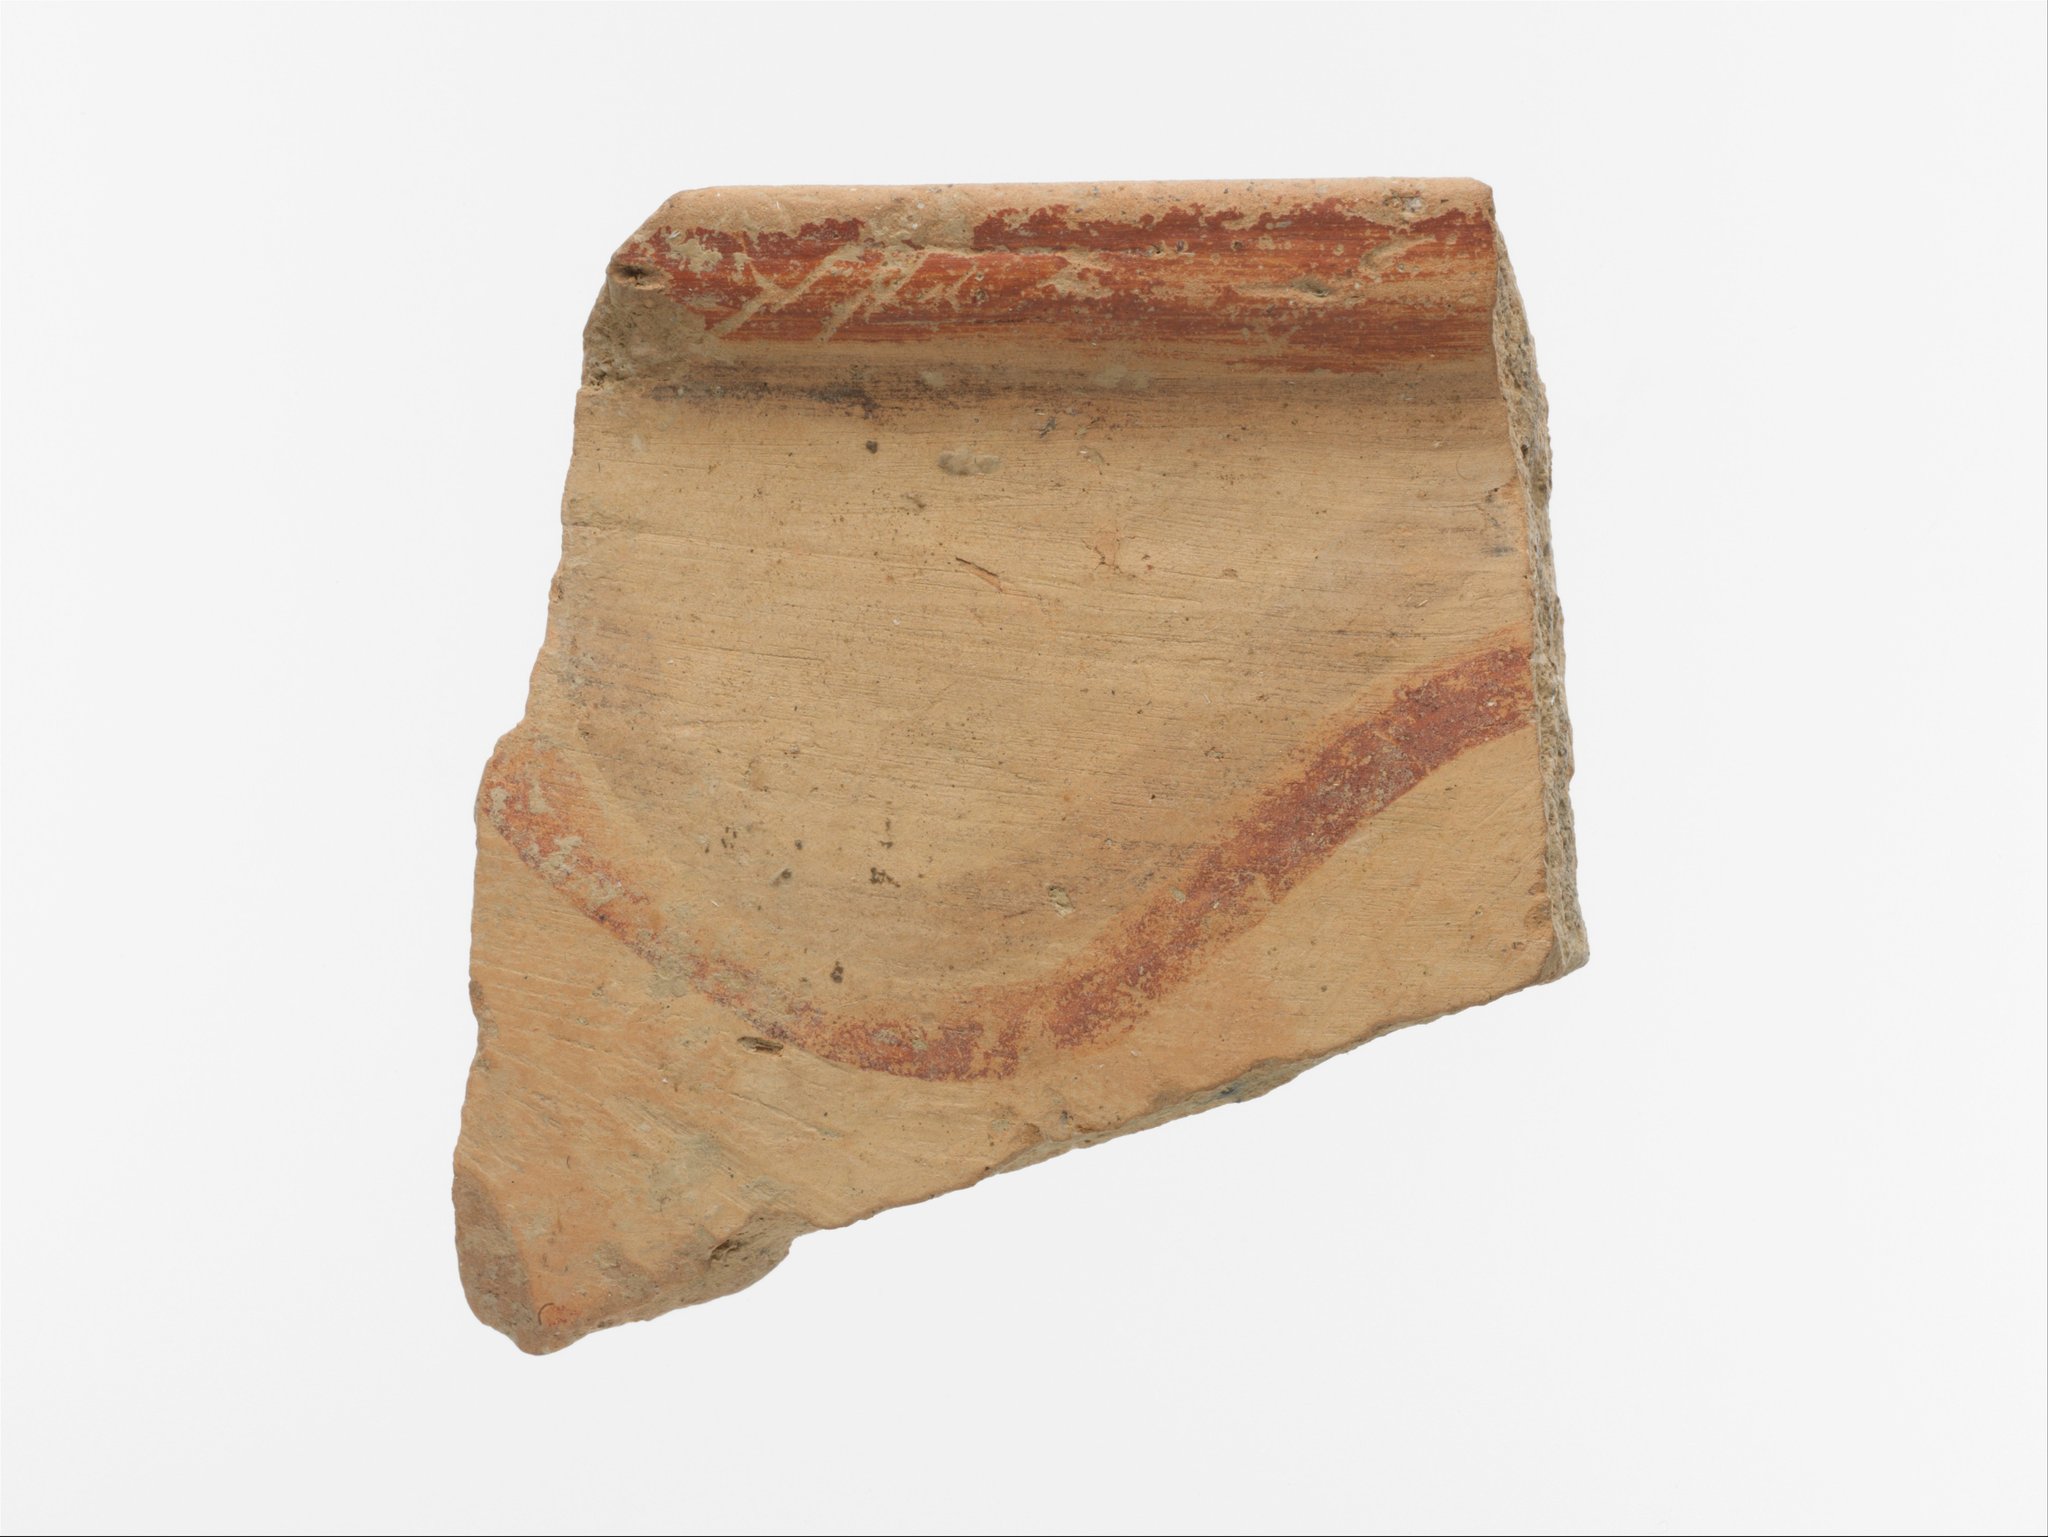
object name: vase fragment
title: Terracotta rim of a vase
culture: helladic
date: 2000-1600 BCE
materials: terracotta